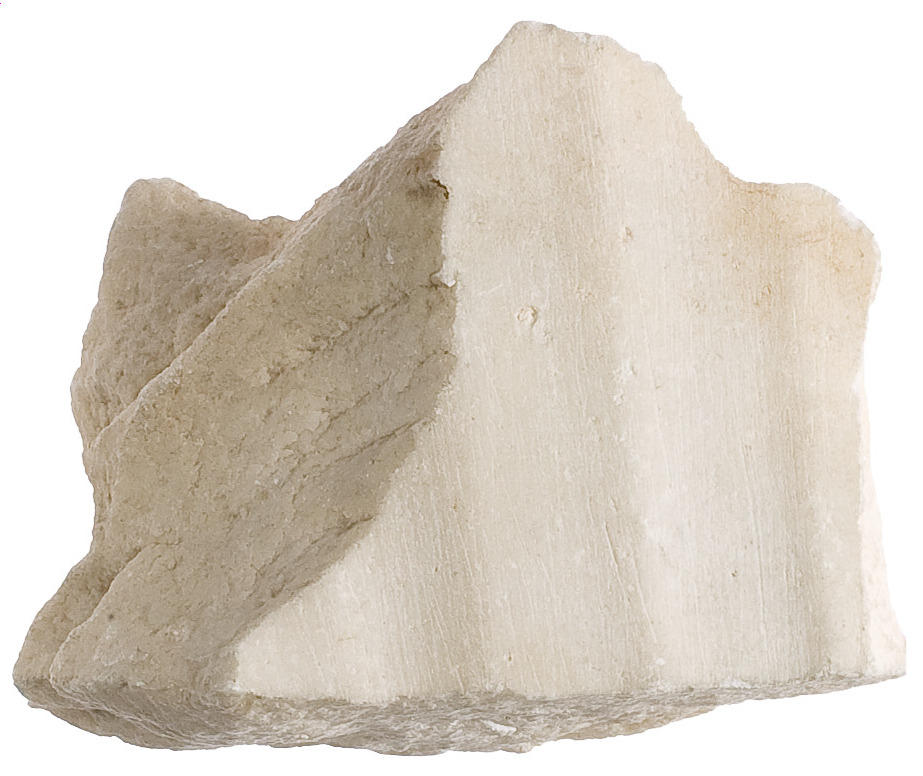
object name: body with garment, pleating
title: Body with pleated garment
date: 1353-1336 BCE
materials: limestone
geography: egypt